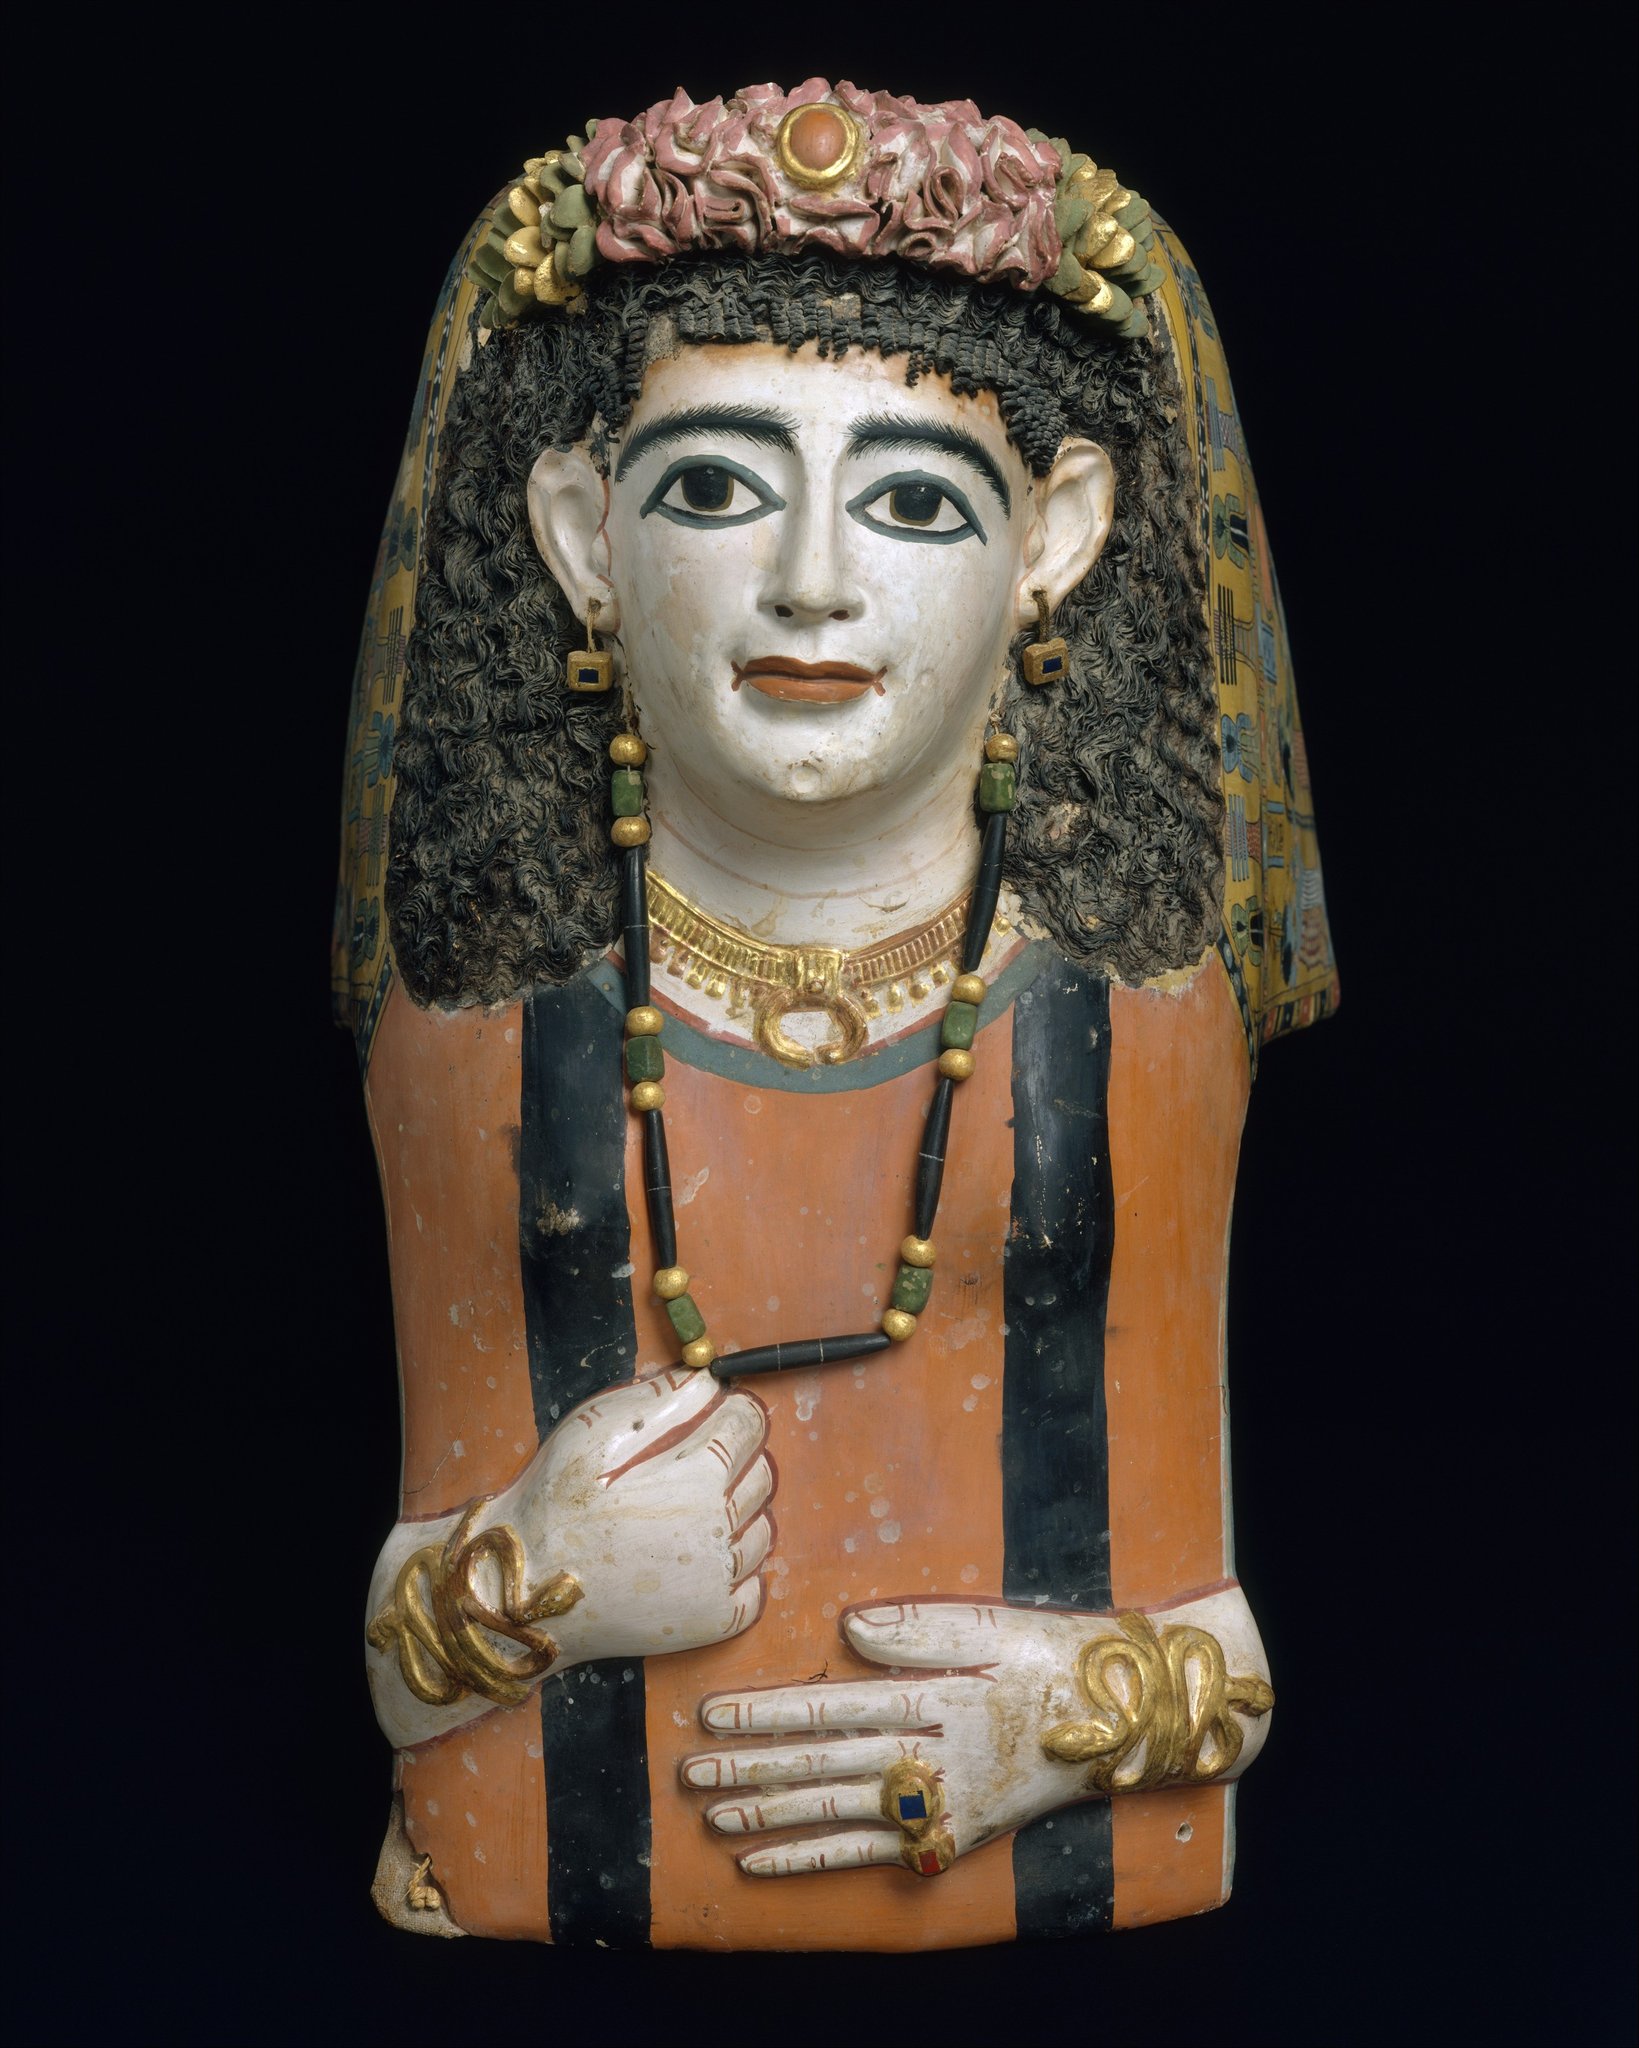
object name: mask, cartonnage, woman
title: Mummy Mask of a Woman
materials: fiber, paint, plaster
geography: middle egypt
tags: masks,women